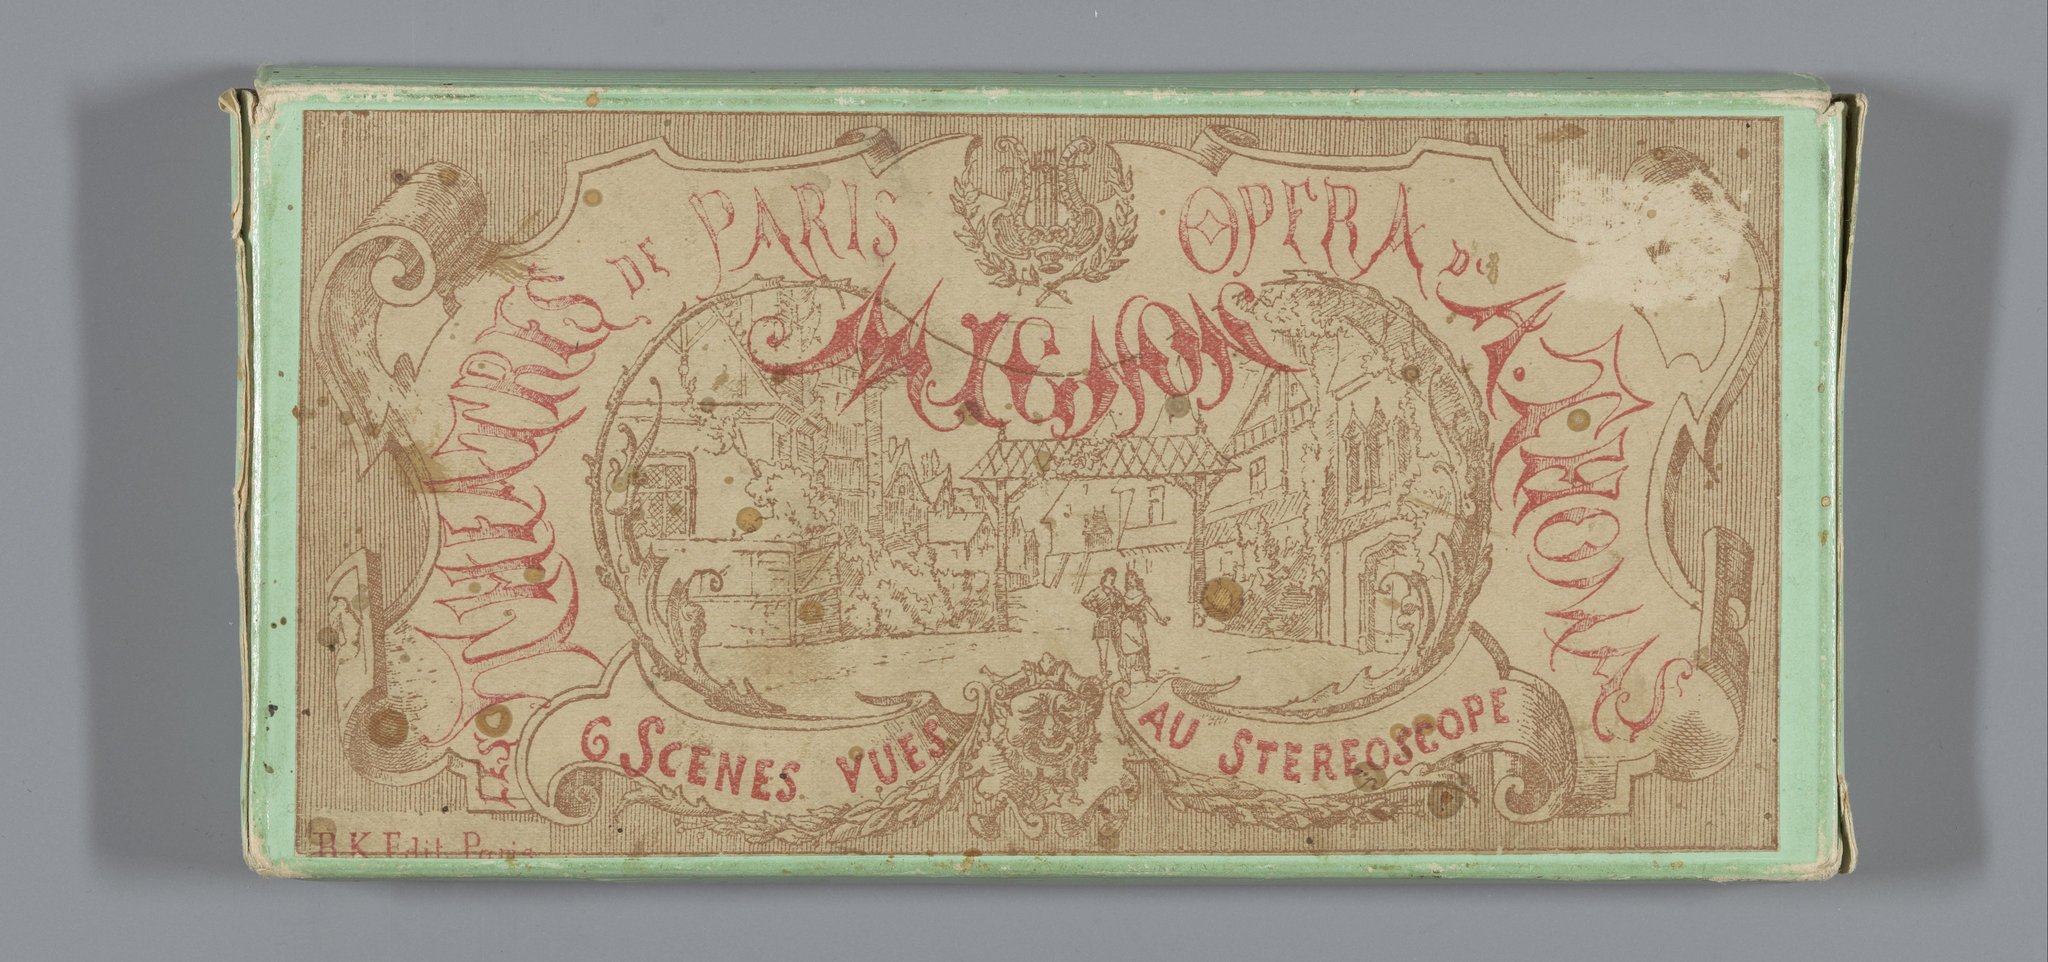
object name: box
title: Doos ter verpakking van 6 stereofoto's van het theater in Parijs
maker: Anonymous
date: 1867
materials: cardboard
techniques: printing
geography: paris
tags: paris